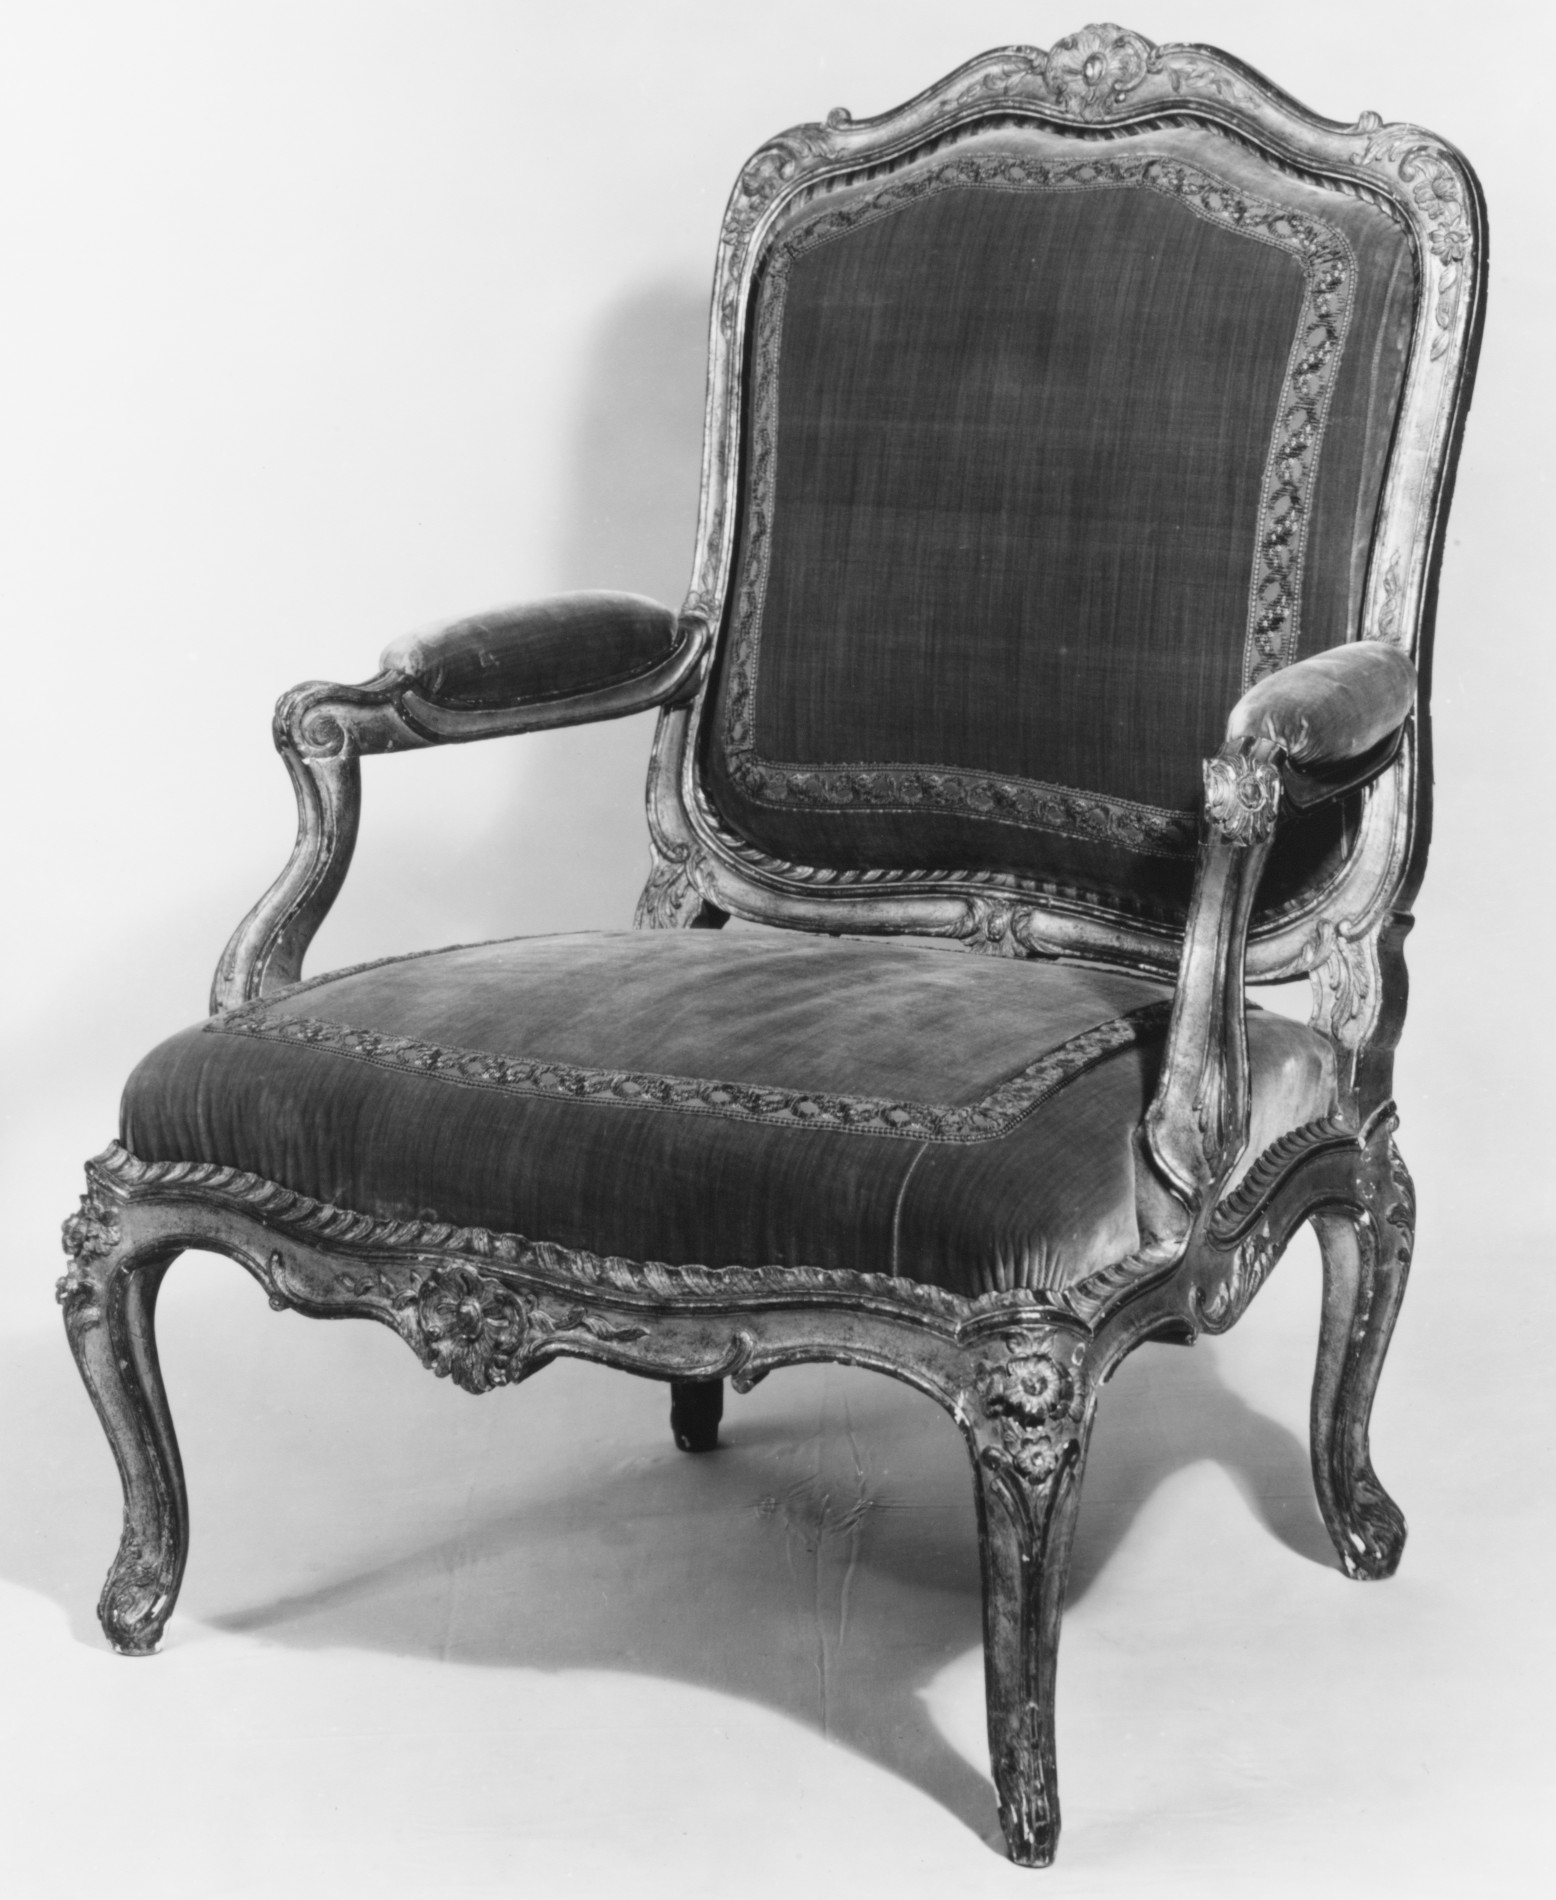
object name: armchair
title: Armchair (one of a pair)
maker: louis i cresson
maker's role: maker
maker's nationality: french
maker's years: 1706-1761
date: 1760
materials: wood, velvet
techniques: carving, gilding